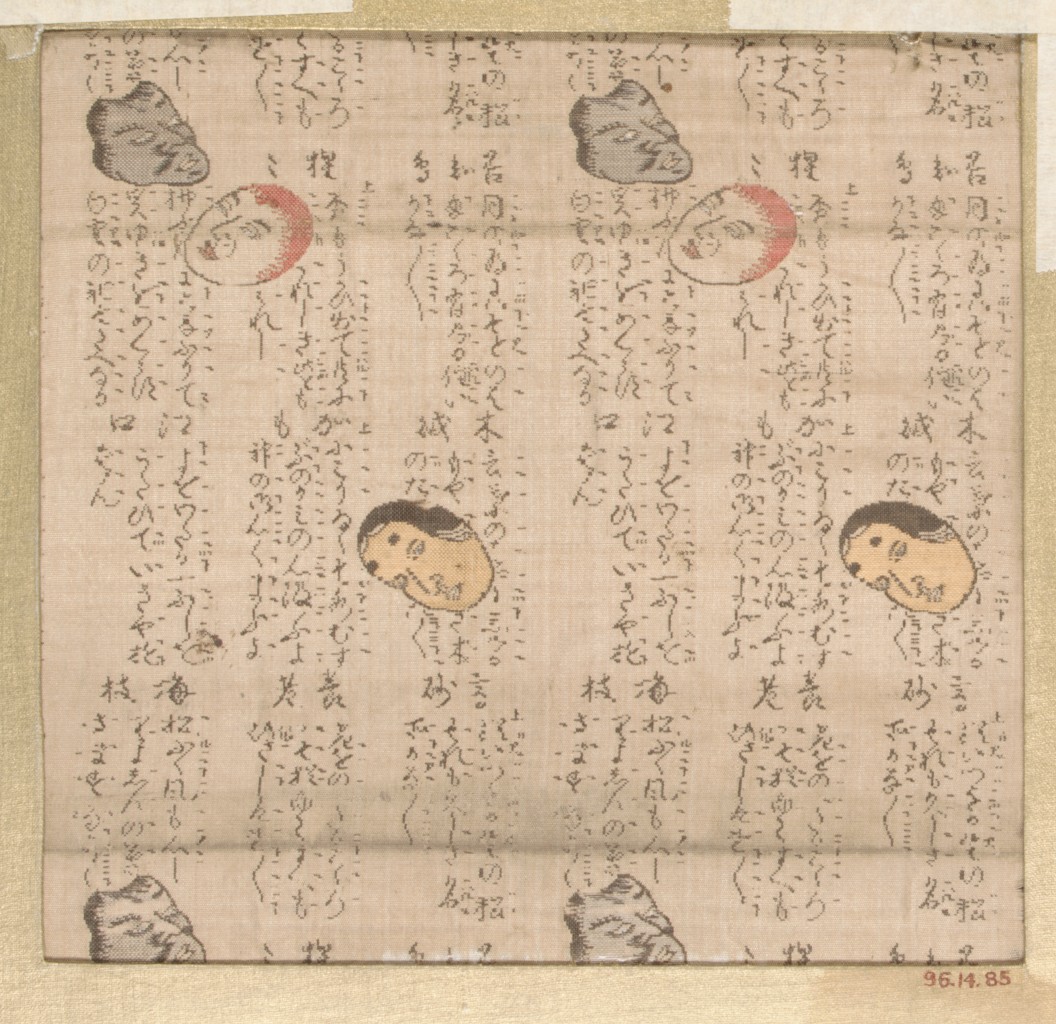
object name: piece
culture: japanese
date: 1701-1900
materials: silk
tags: masks